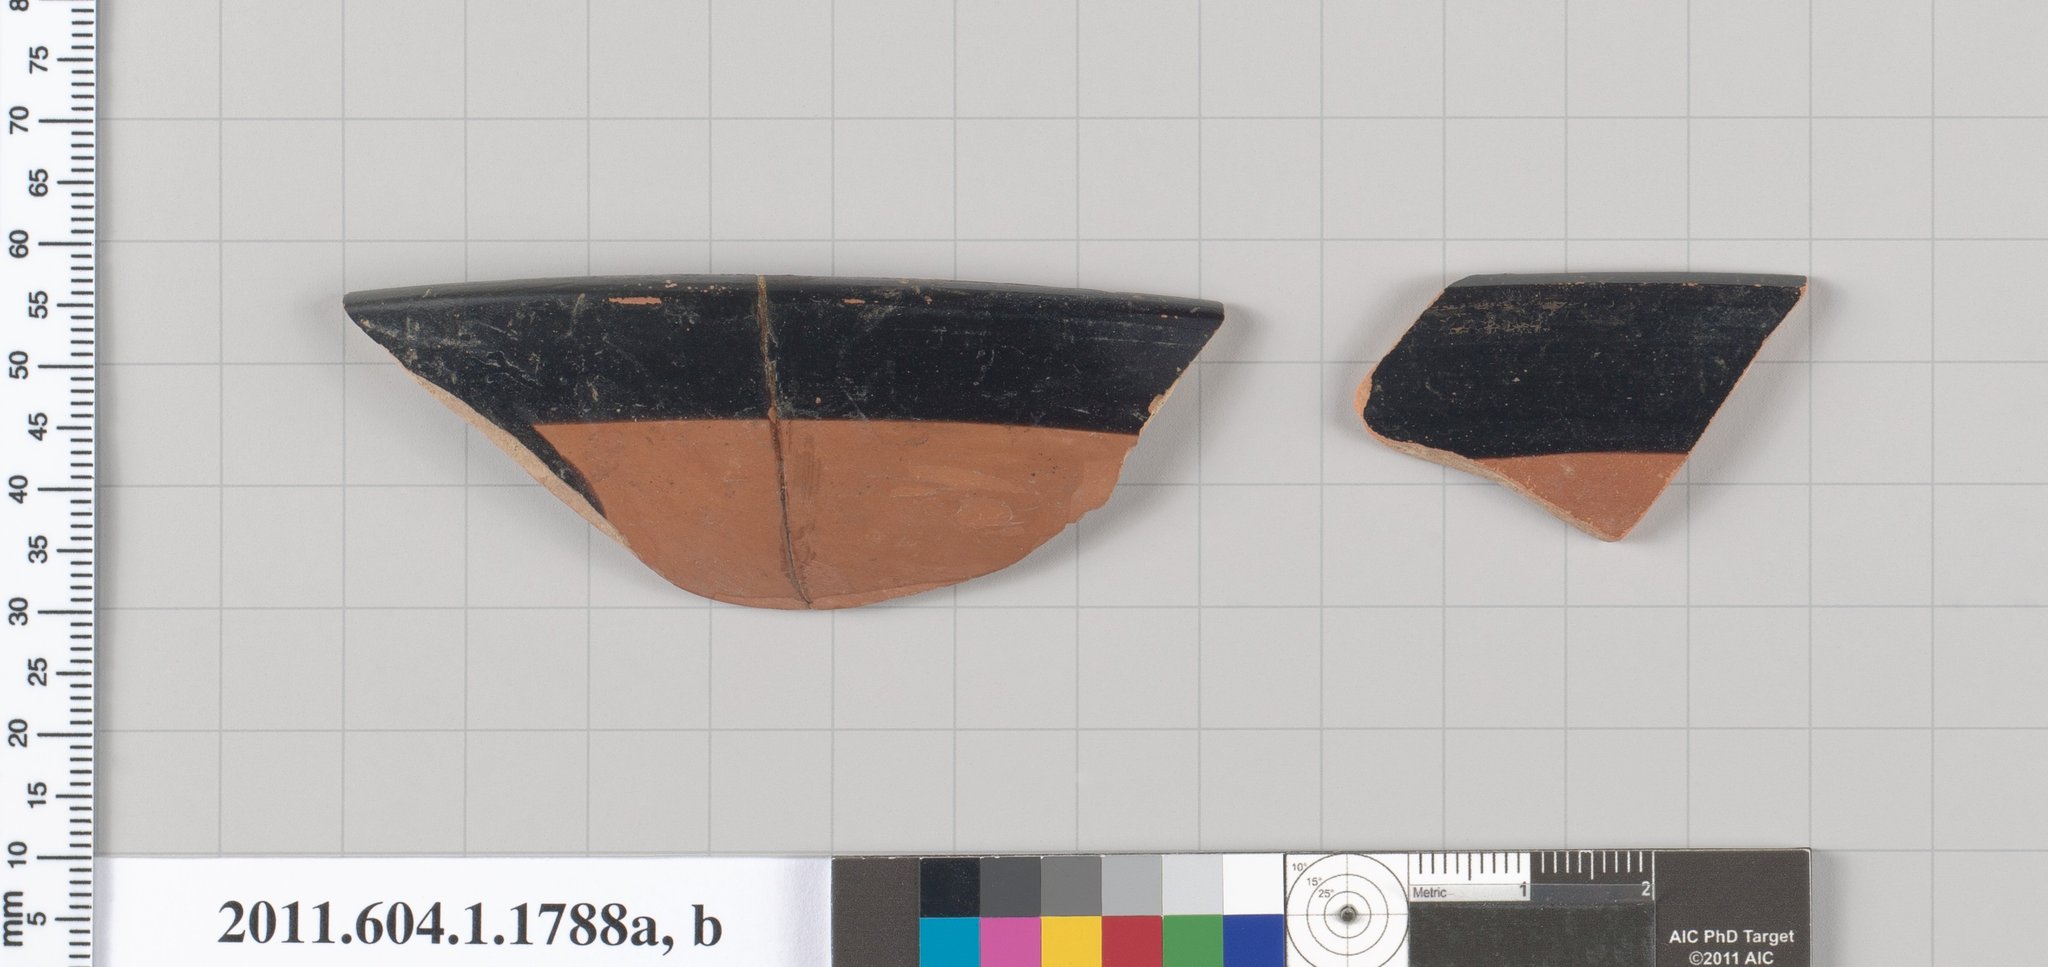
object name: kylix fragment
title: Terracotta rim fragments of kylikes(drinking cups)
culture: greek, attic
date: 500-401 BCE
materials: terracotta